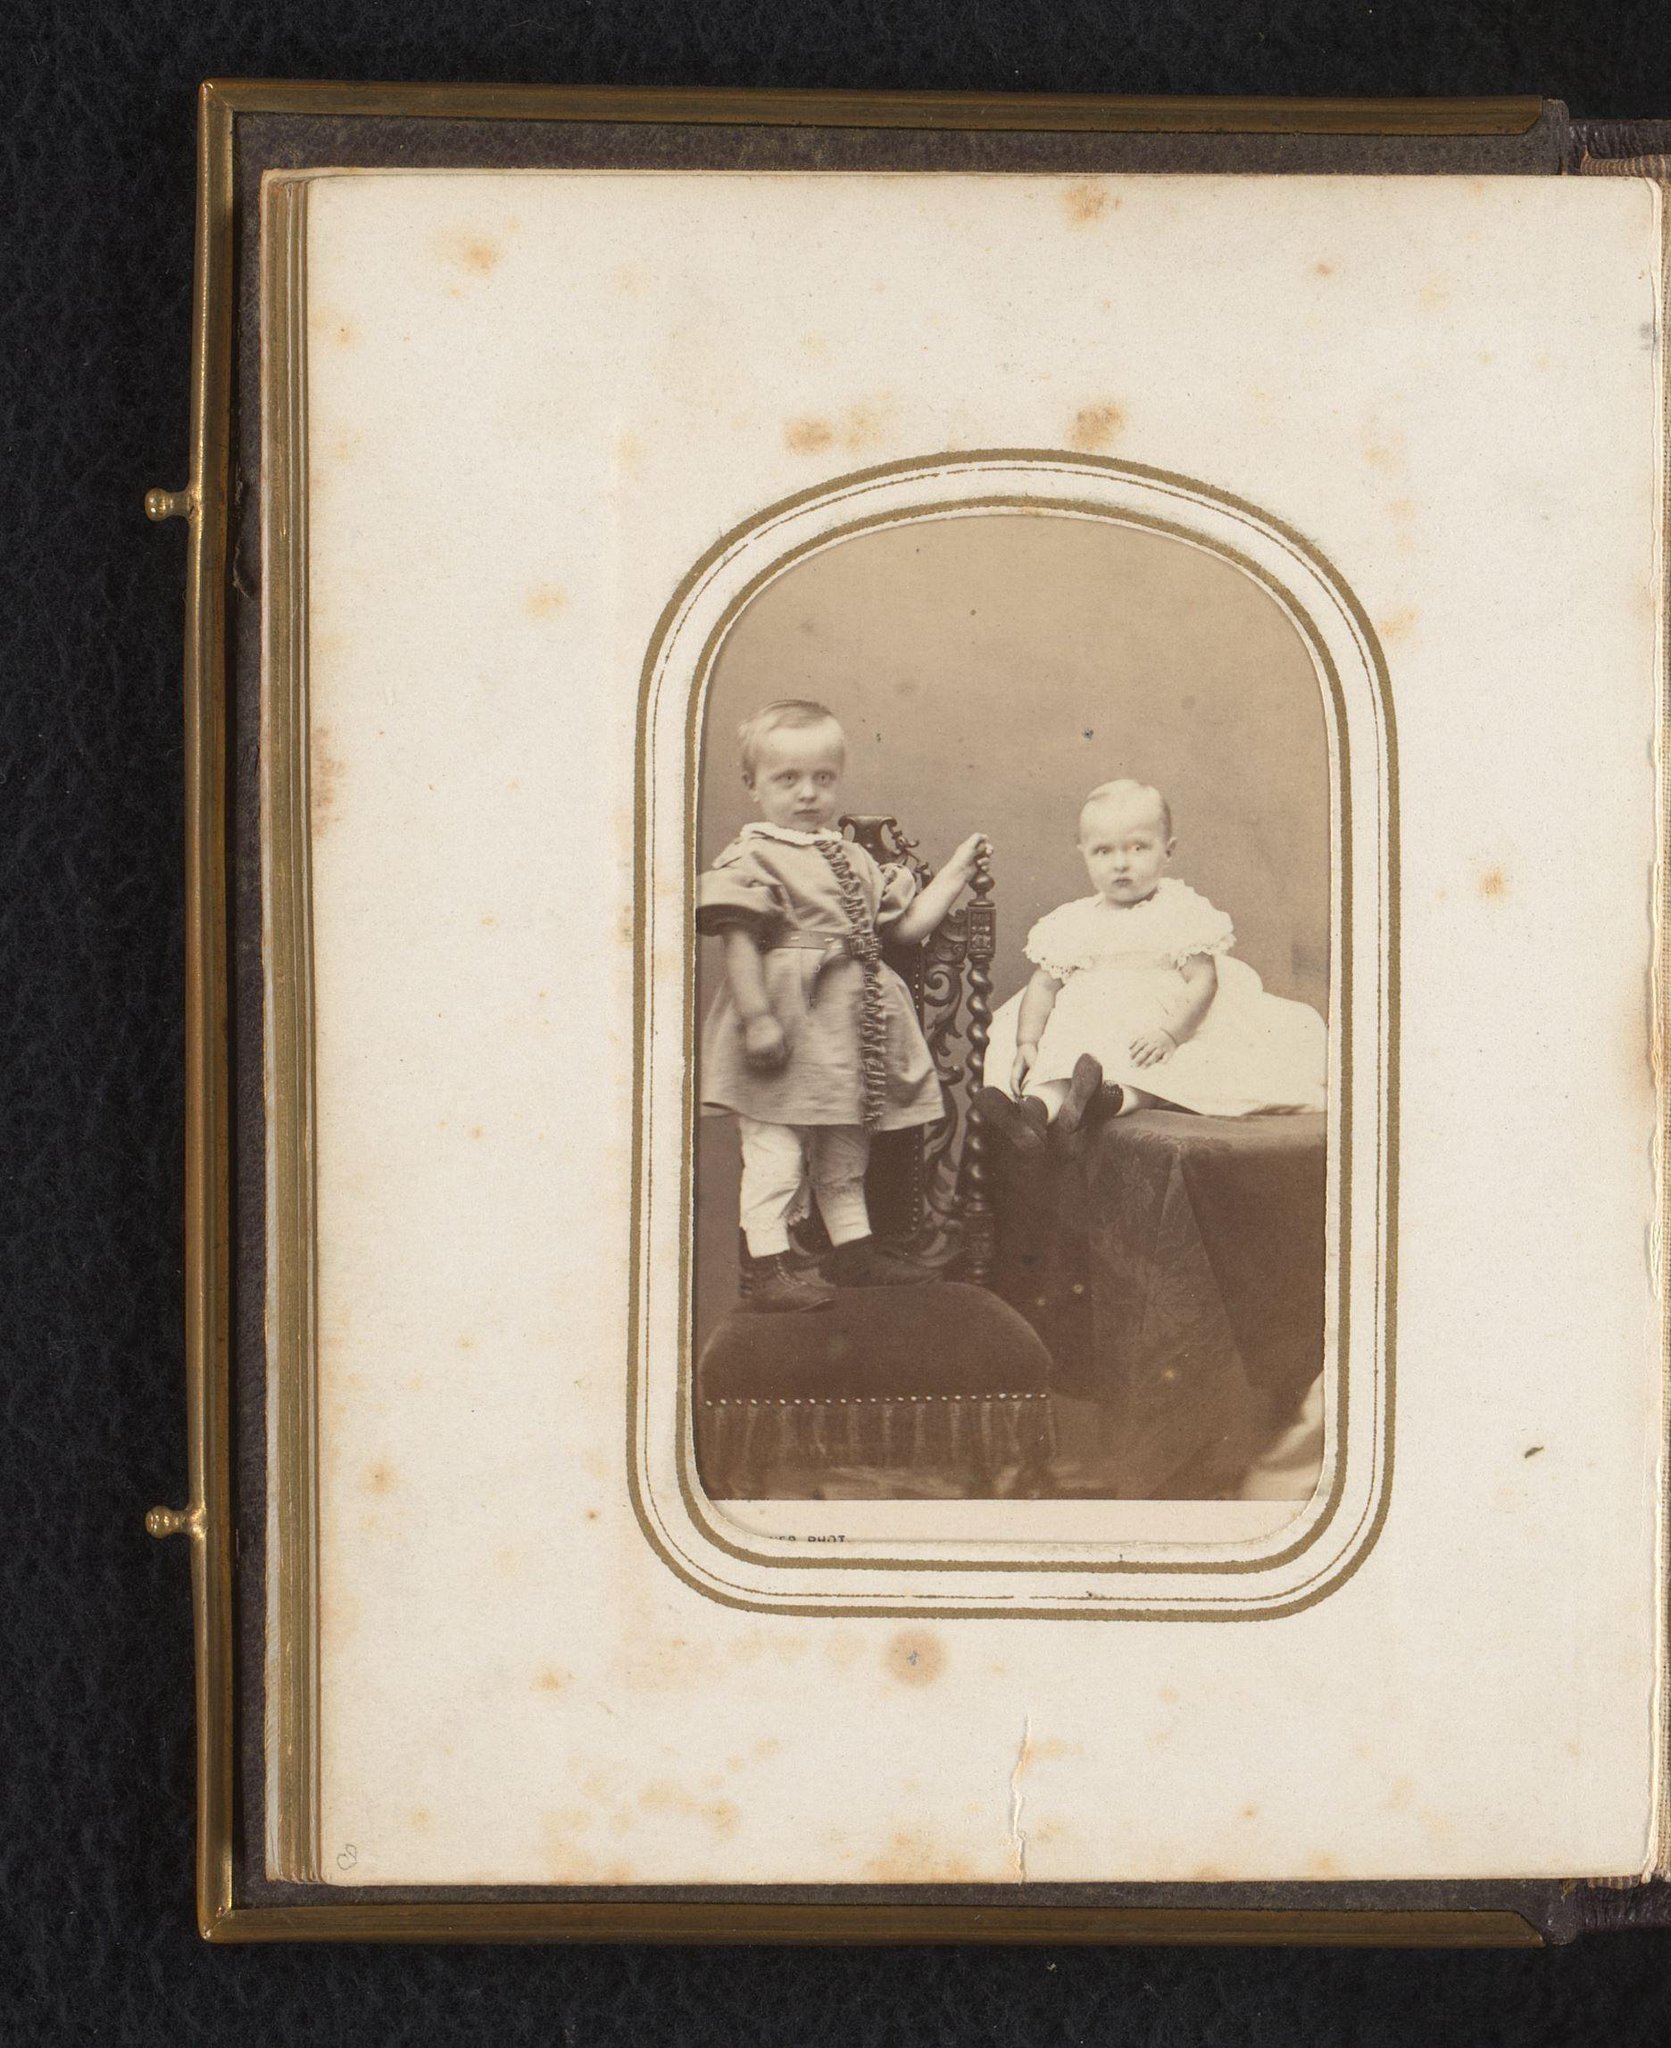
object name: photograph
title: Portret van een peuter en een baby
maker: albert greiner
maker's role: fotograaf, fotostudio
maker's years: 1833-1890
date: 1861-1874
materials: cardboard, photographic support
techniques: albumen print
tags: toddler, historical persons, infant, baby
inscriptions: inscription: ‘A. Greiner/ photograf/ Nieuwendijk L 87/ Amsterdam’